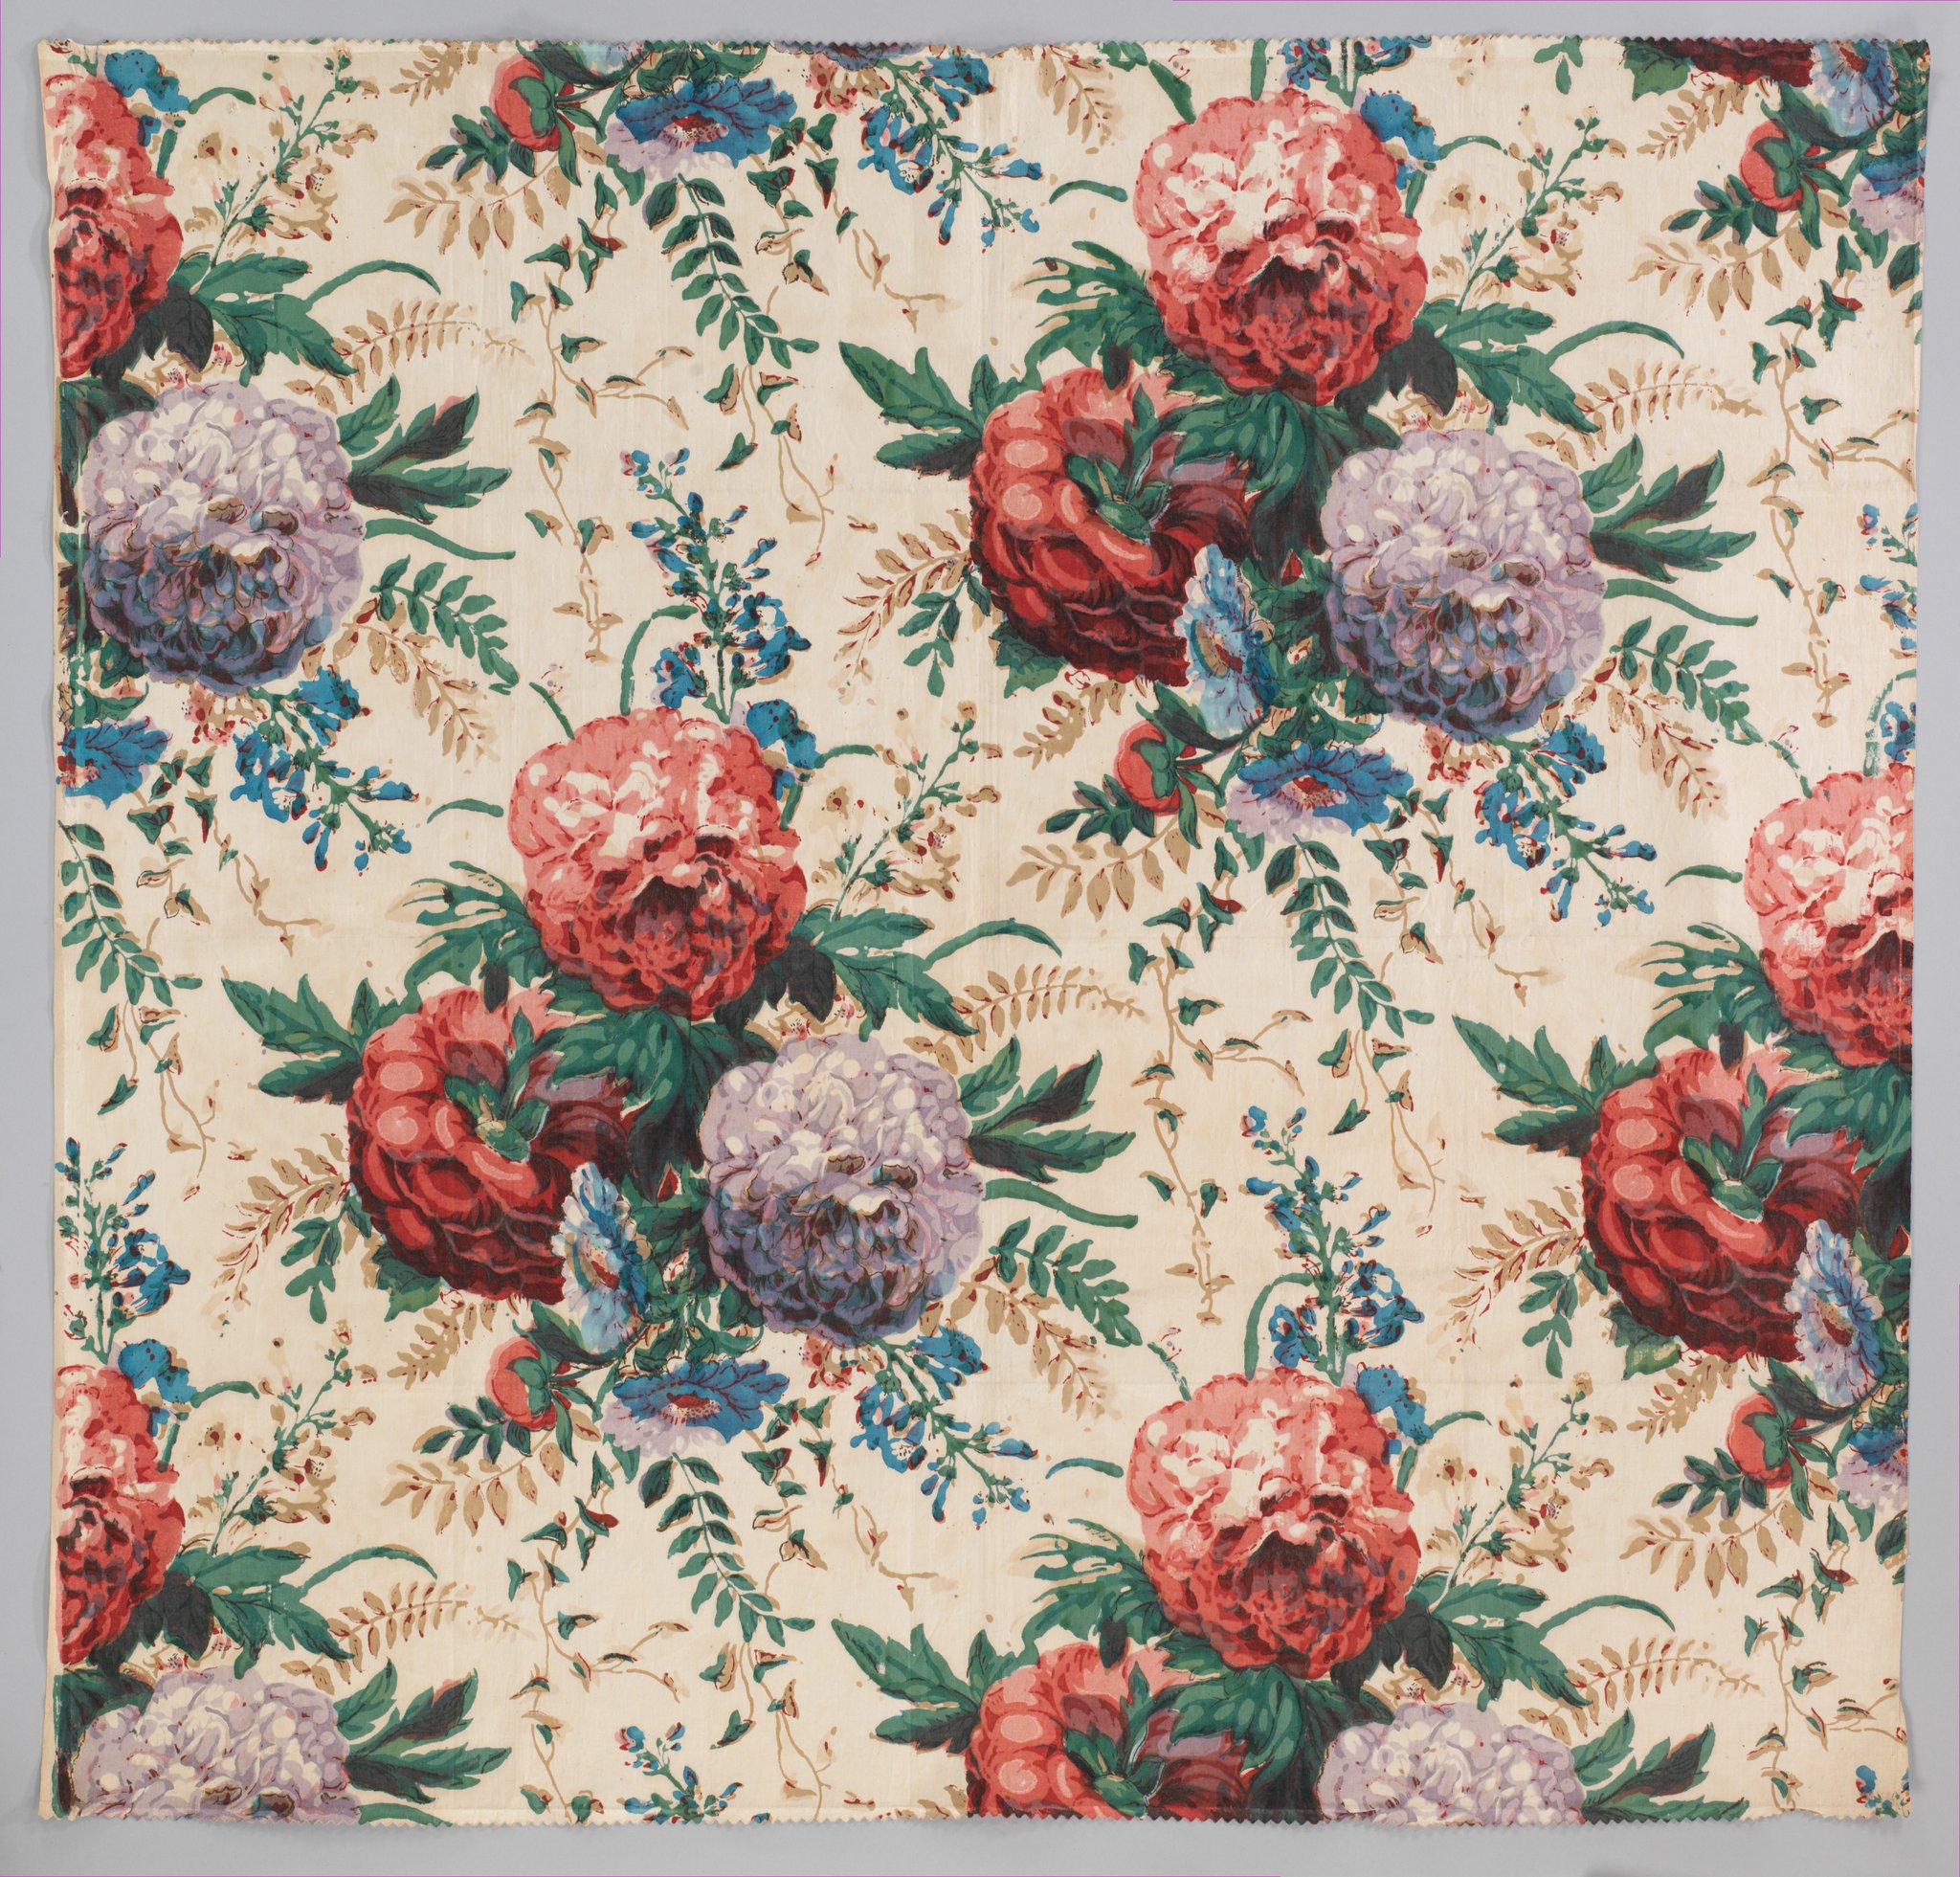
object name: piece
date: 1851-1872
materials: cotton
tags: flowers